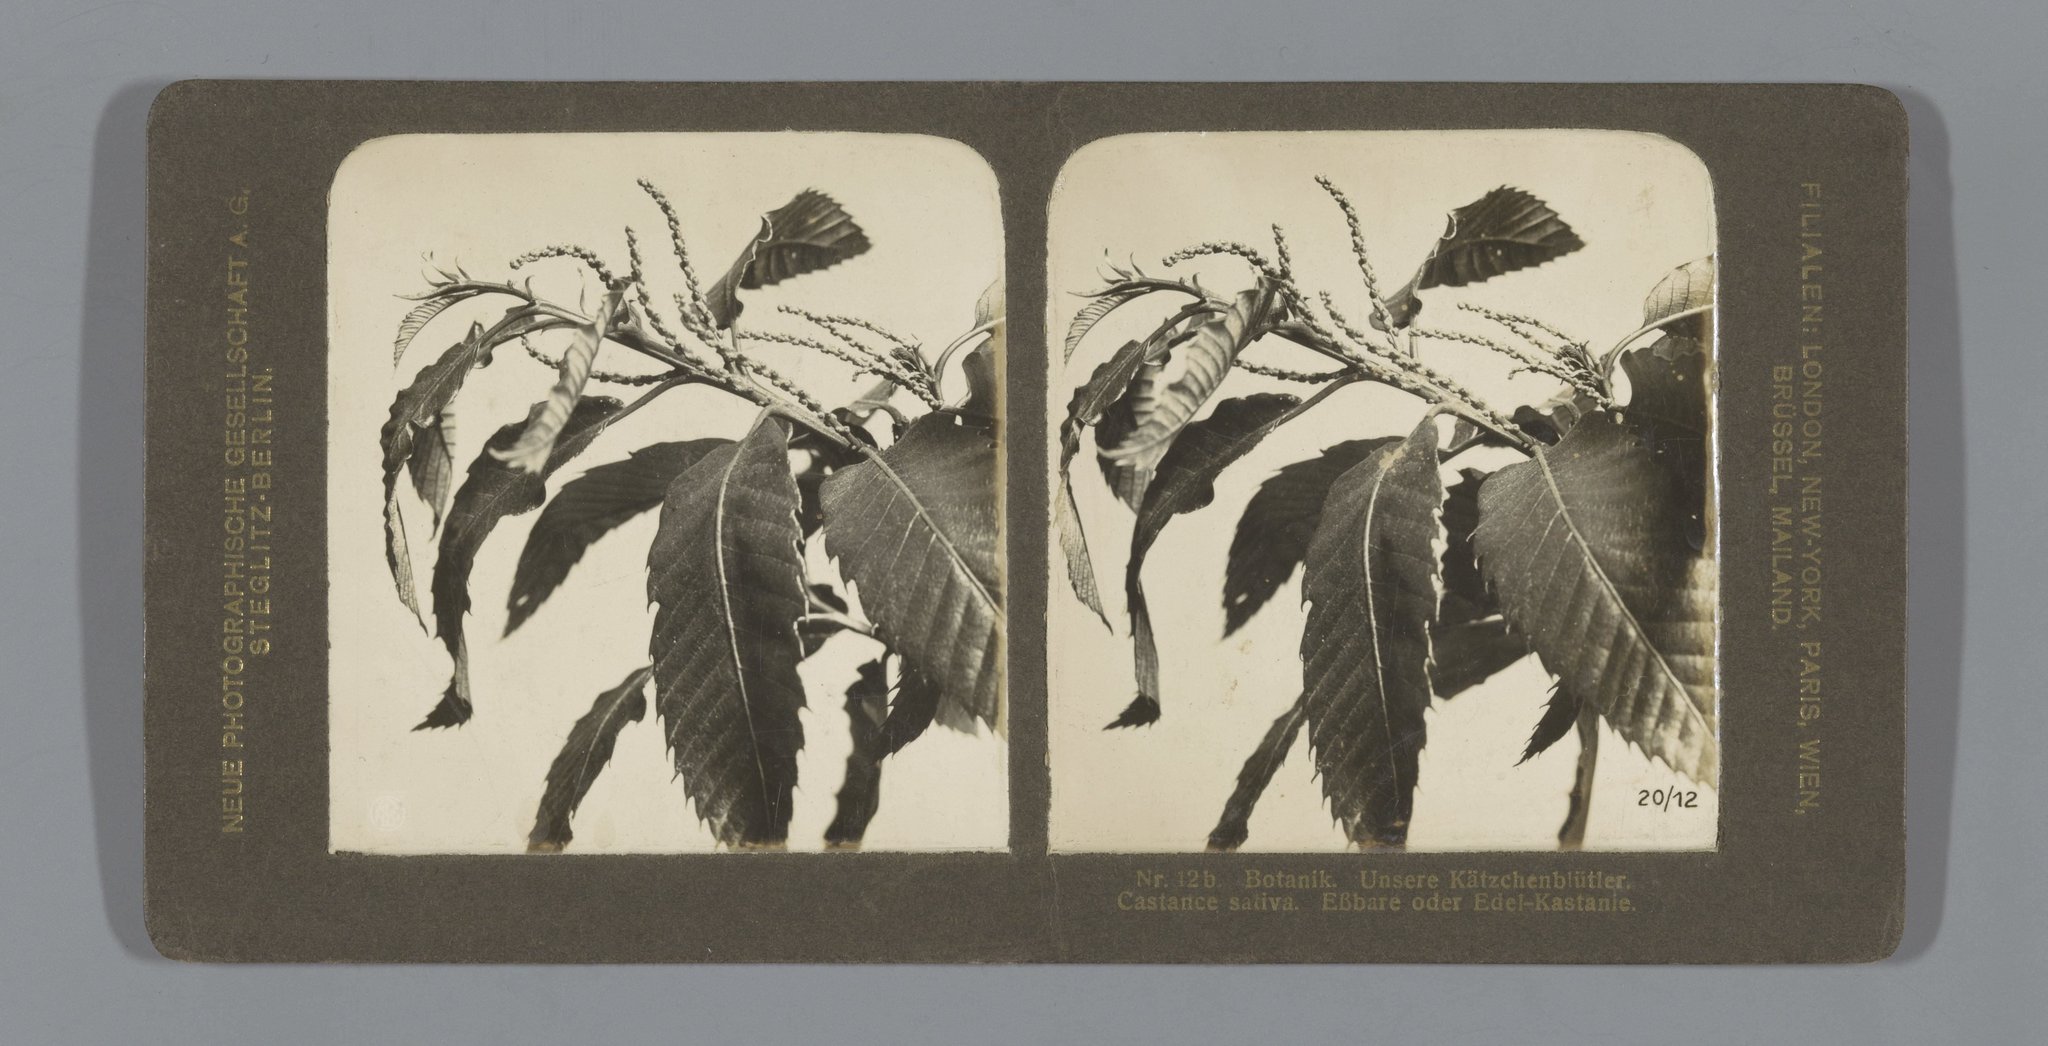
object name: stereograph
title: Nr. 12b. Botanik. Unsere Kätzchenblütler. Castance sativa. Essbare oder Edel-Kastanie.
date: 1900-1920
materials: cardboard, photographic support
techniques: gelatin silver print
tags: fruits: chestnut, botanic garden, 'hortus botanicus'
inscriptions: : ‘Steglitz-Berlin’, : ‘Filialen: London, New-York, Paris, Wien, Brussel, Mailand’, number: ‘20/12’